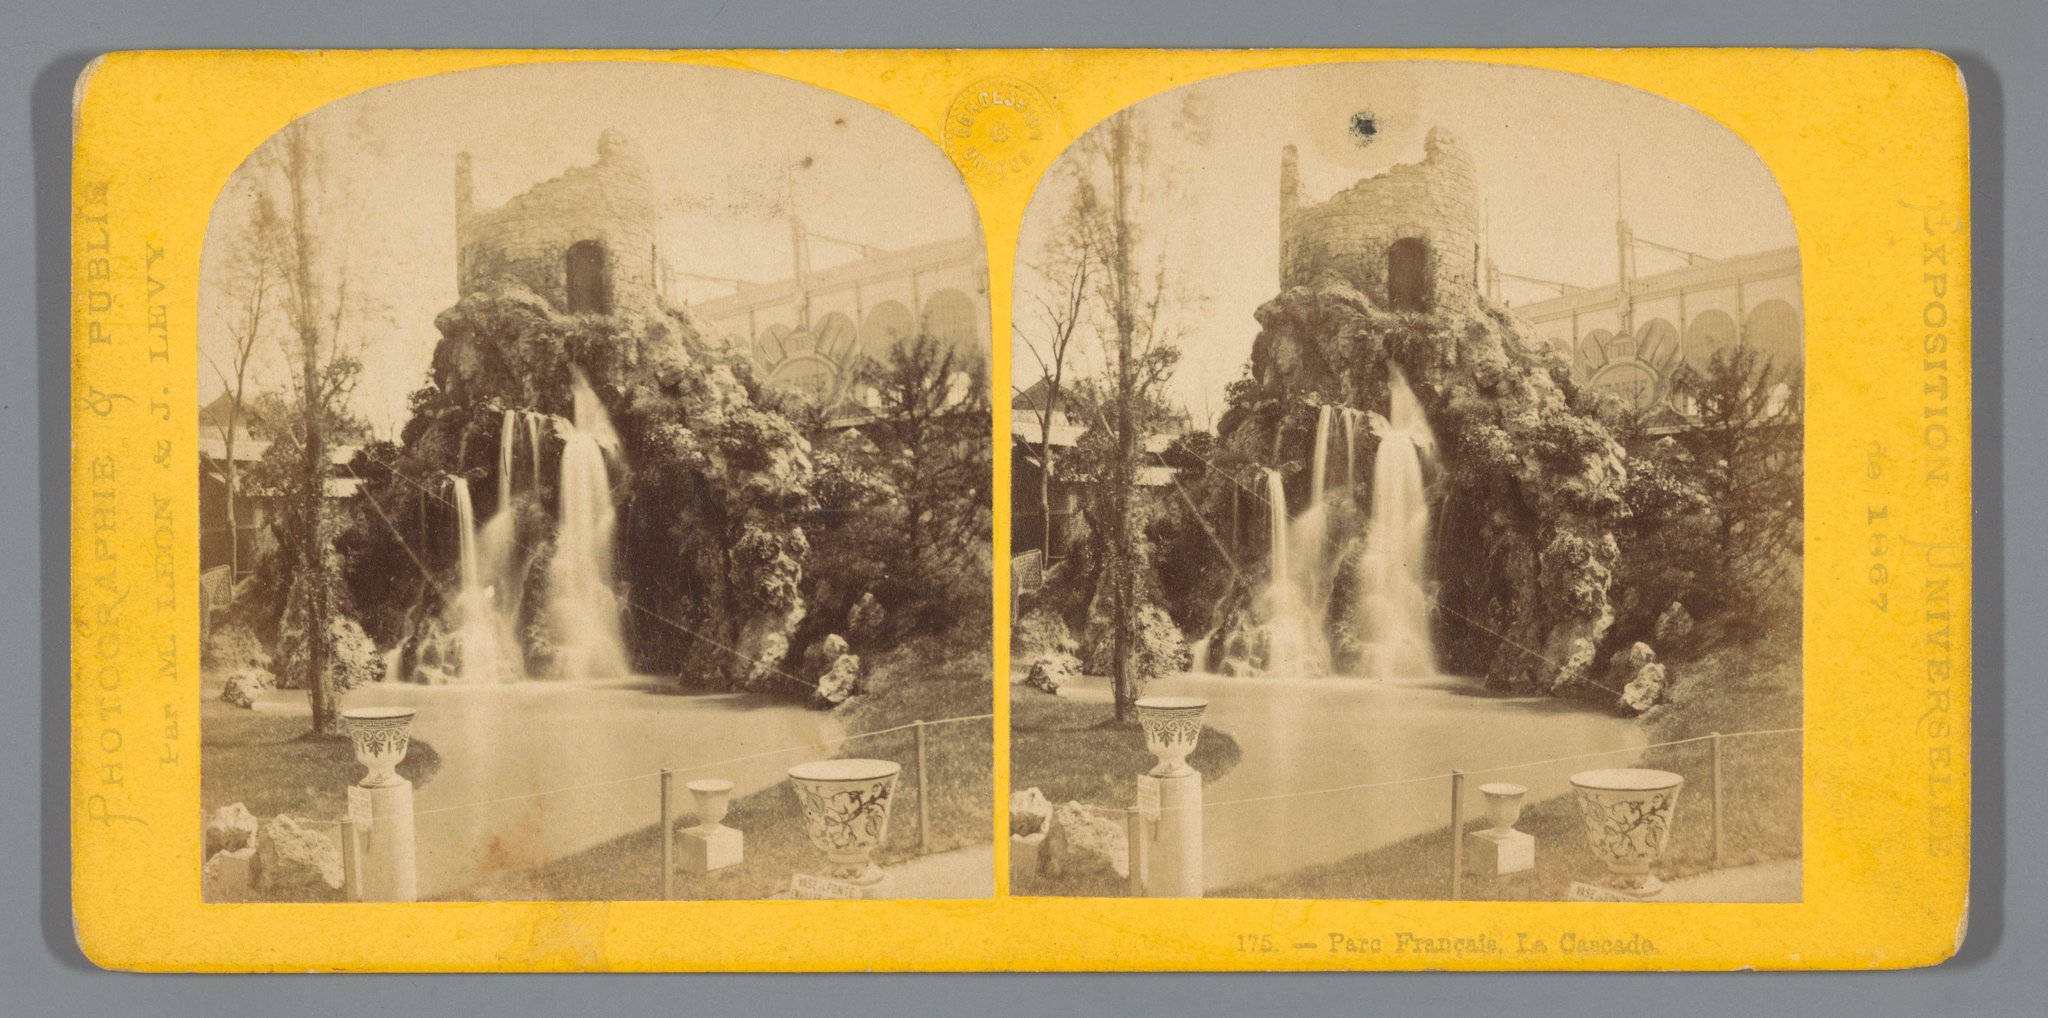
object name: stereograph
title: Kunstmatige waterval in het parc français tijdens de Wereldtentoonstelling van 1867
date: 1867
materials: cardboard, paper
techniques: albumen print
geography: paris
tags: world fair, world exhibition, garden cascade, paris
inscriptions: check stamp: ‘CONCESSION/ */ UNIQUE’, inscription: ‘32.’